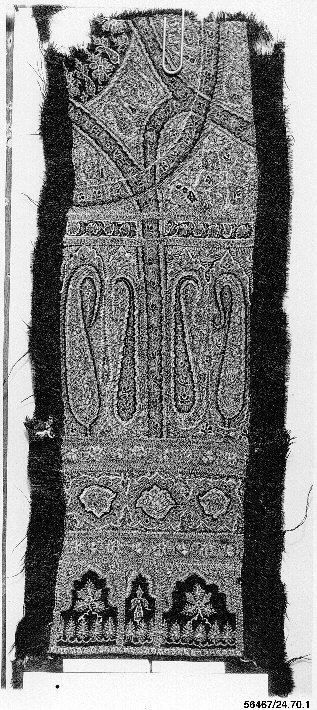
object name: shawl fragment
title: Shawl Sample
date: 1801-1833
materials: wool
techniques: embroidery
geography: india